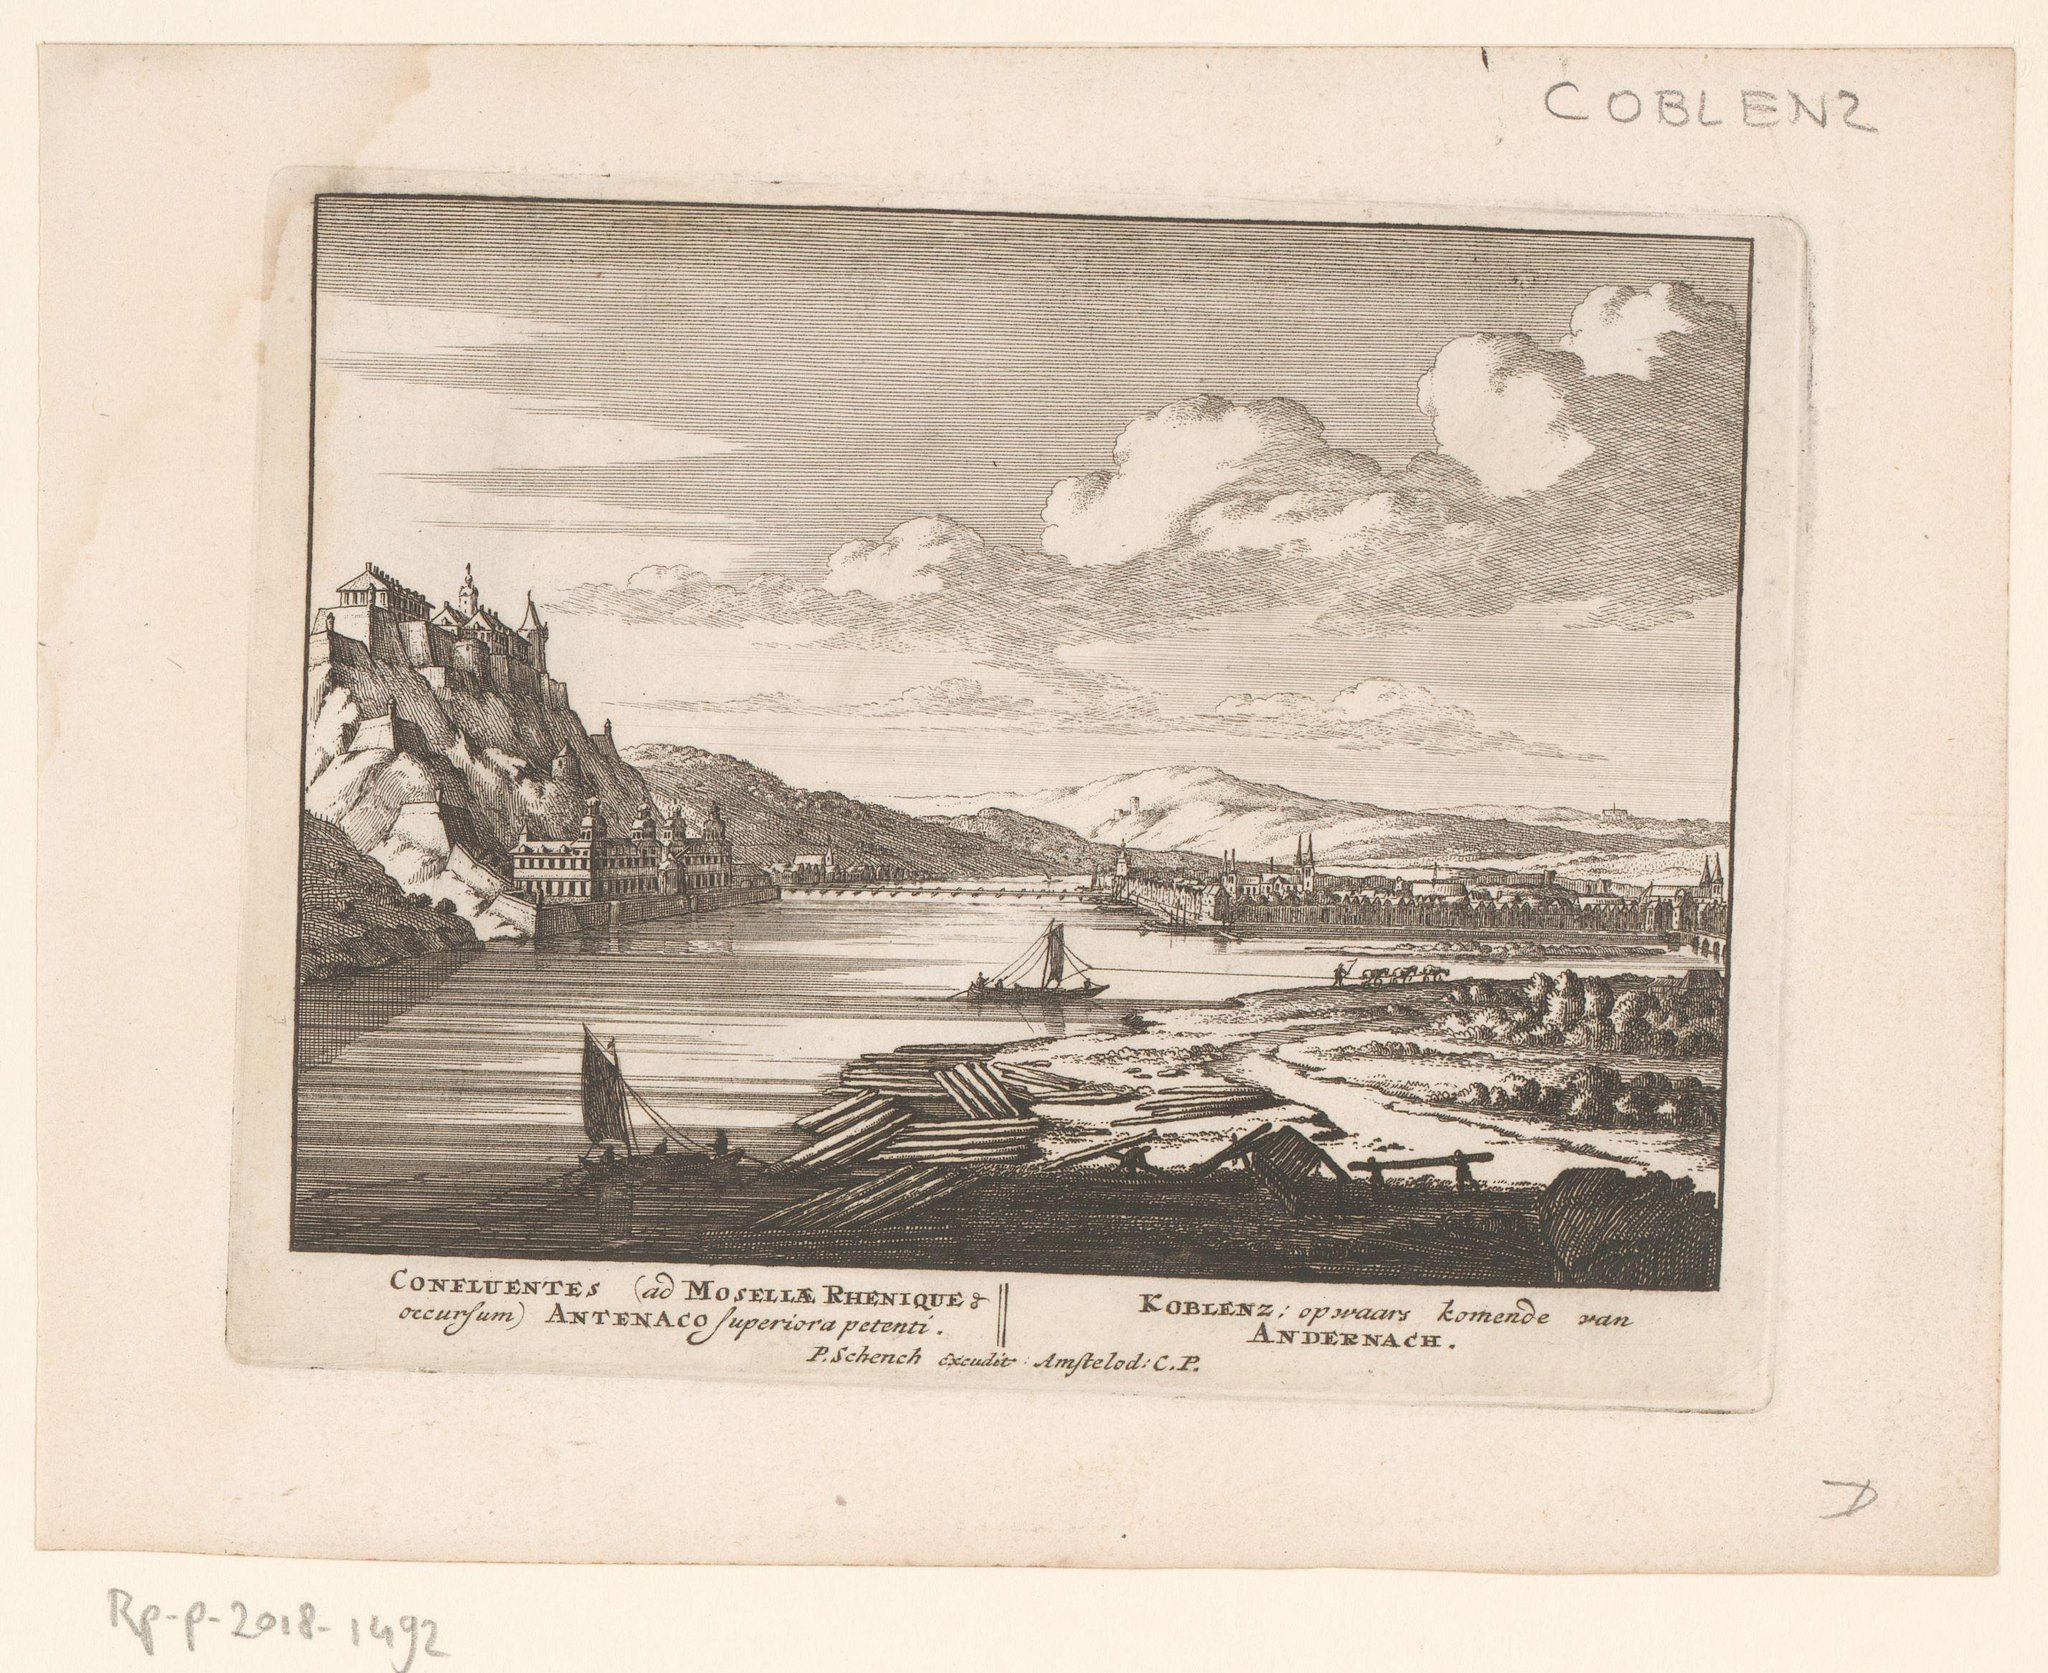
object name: print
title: Gezicht op Koblenz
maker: pieter schenk (i)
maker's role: print maker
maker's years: 1660-1711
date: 1694-1697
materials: paper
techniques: engraving, etching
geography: amsterdam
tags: river, prospect of city, town panorama, silhouette of city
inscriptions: collector's mark: Lugt 2228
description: Prent ook gebruikt in: Admirandorum quadruplex spectaculum / delectum, pictum, et aeri in cisum, per Johannem van Call. Amsterdam: Pieter Schenk (I), ca. 1694-1697.